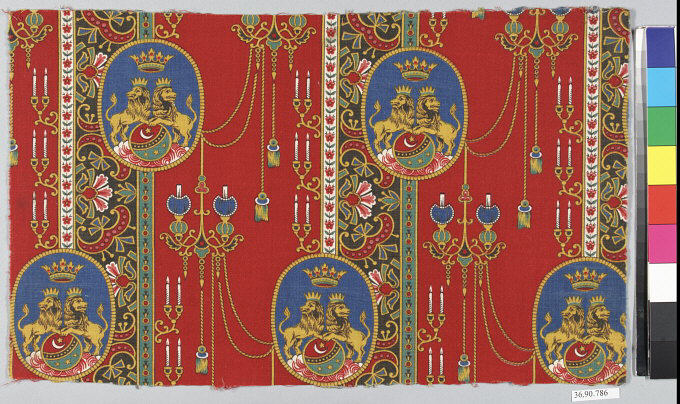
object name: piece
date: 1867-1900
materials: cotton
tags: lions,coat of arms